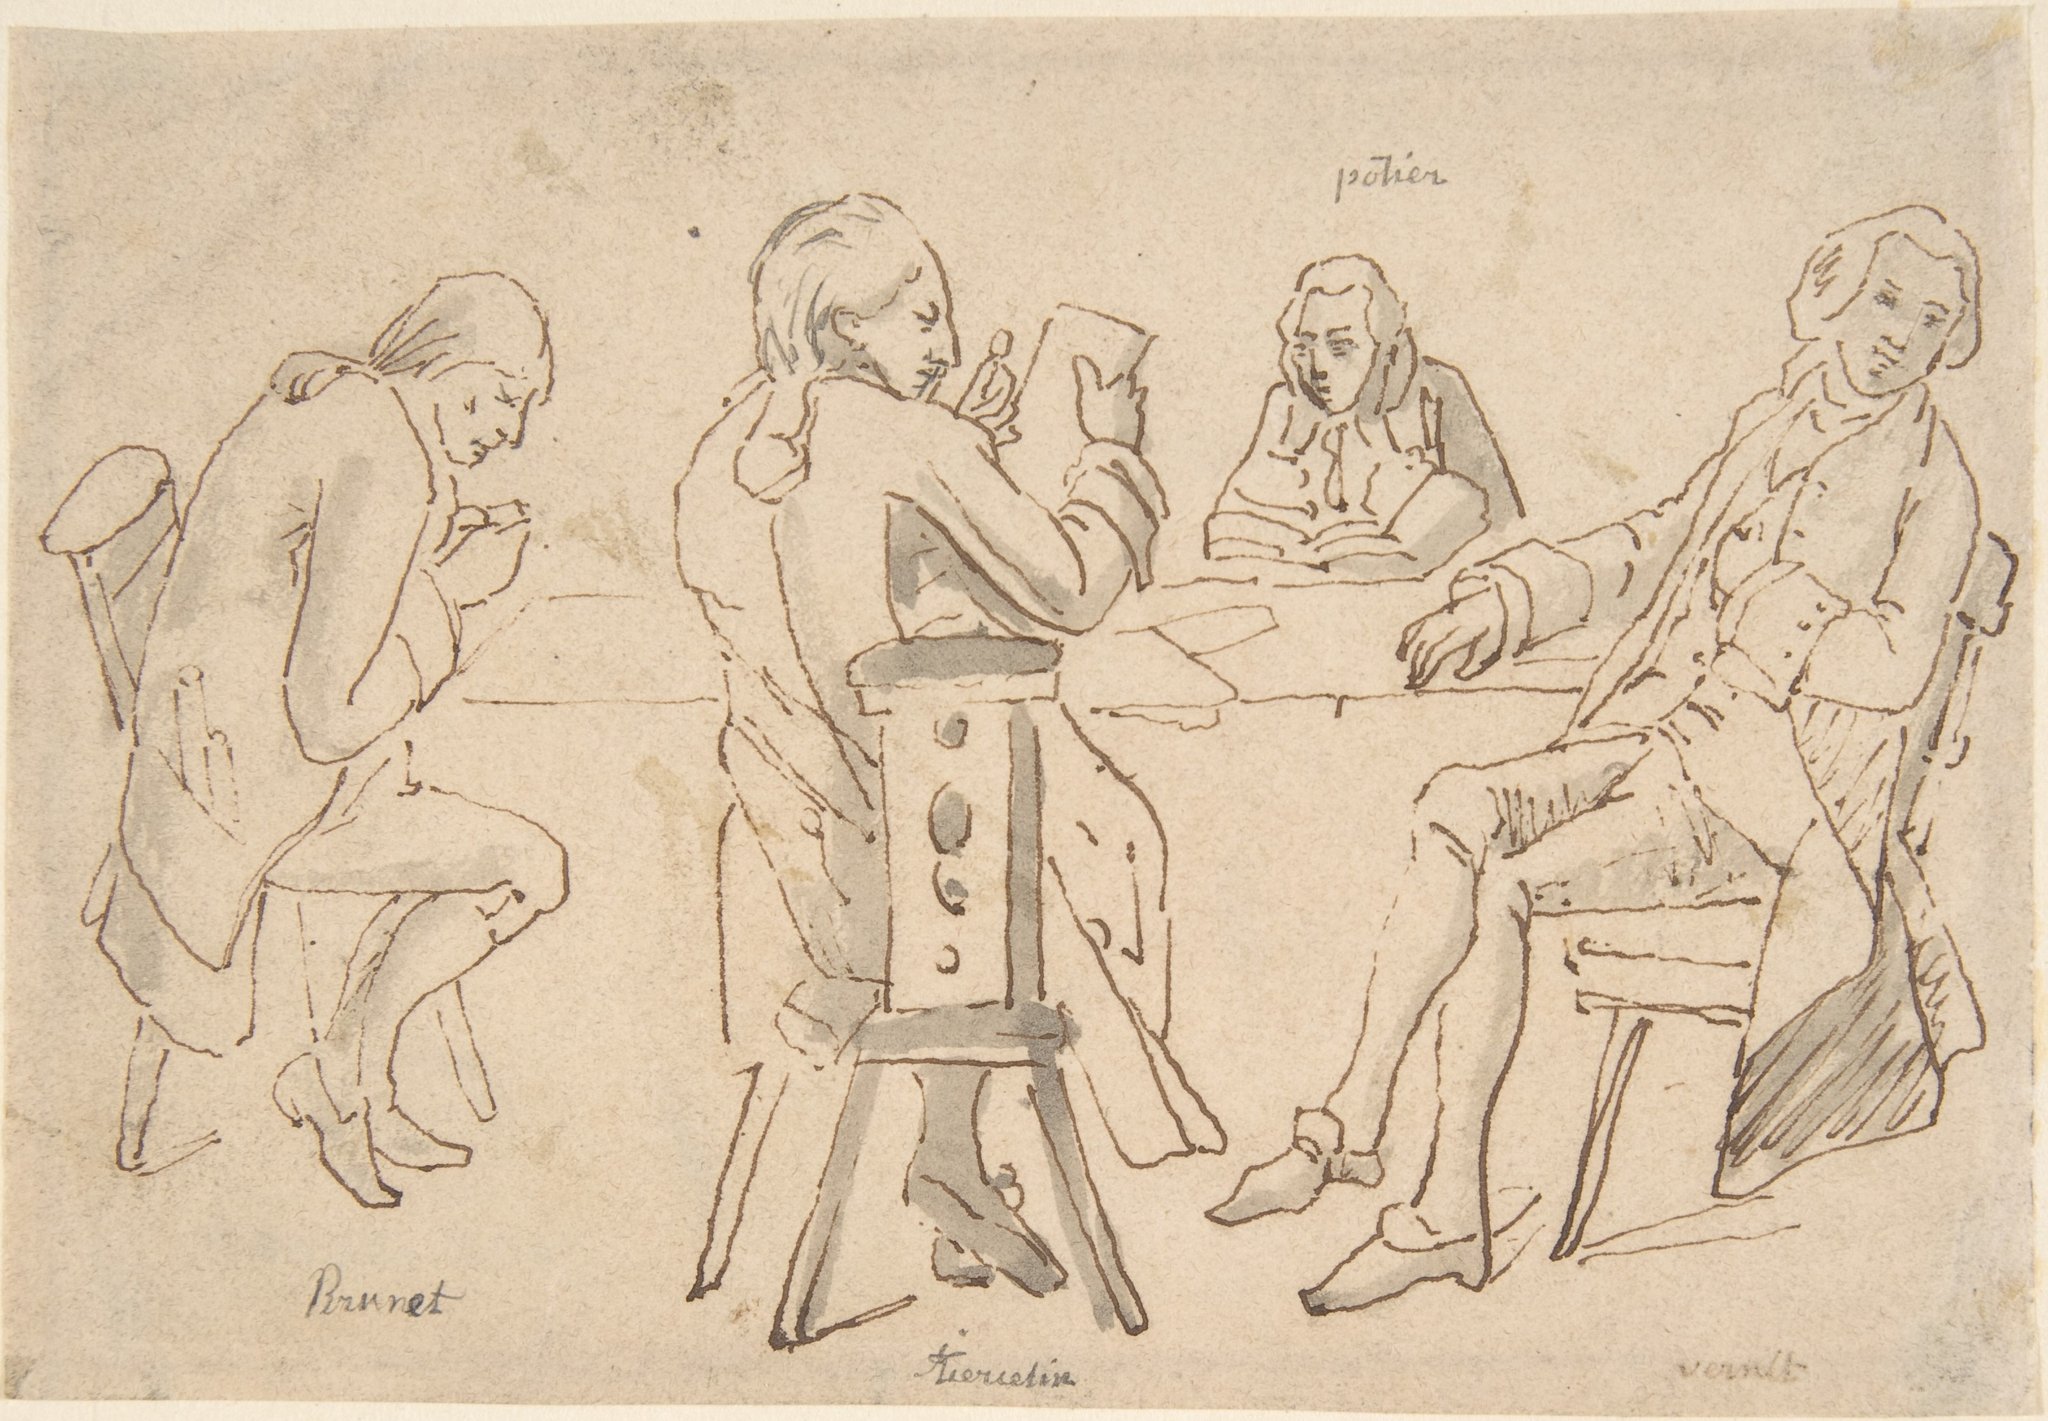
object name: drawing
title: Four Artists seated at a table (Brunet, Potier, Tiercetin [?], Vernet)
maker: carle vernet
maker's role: artist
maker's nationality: french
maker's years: 1758-1836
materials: ink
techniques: brush, pen, wash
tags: men,reading,chairs,tables